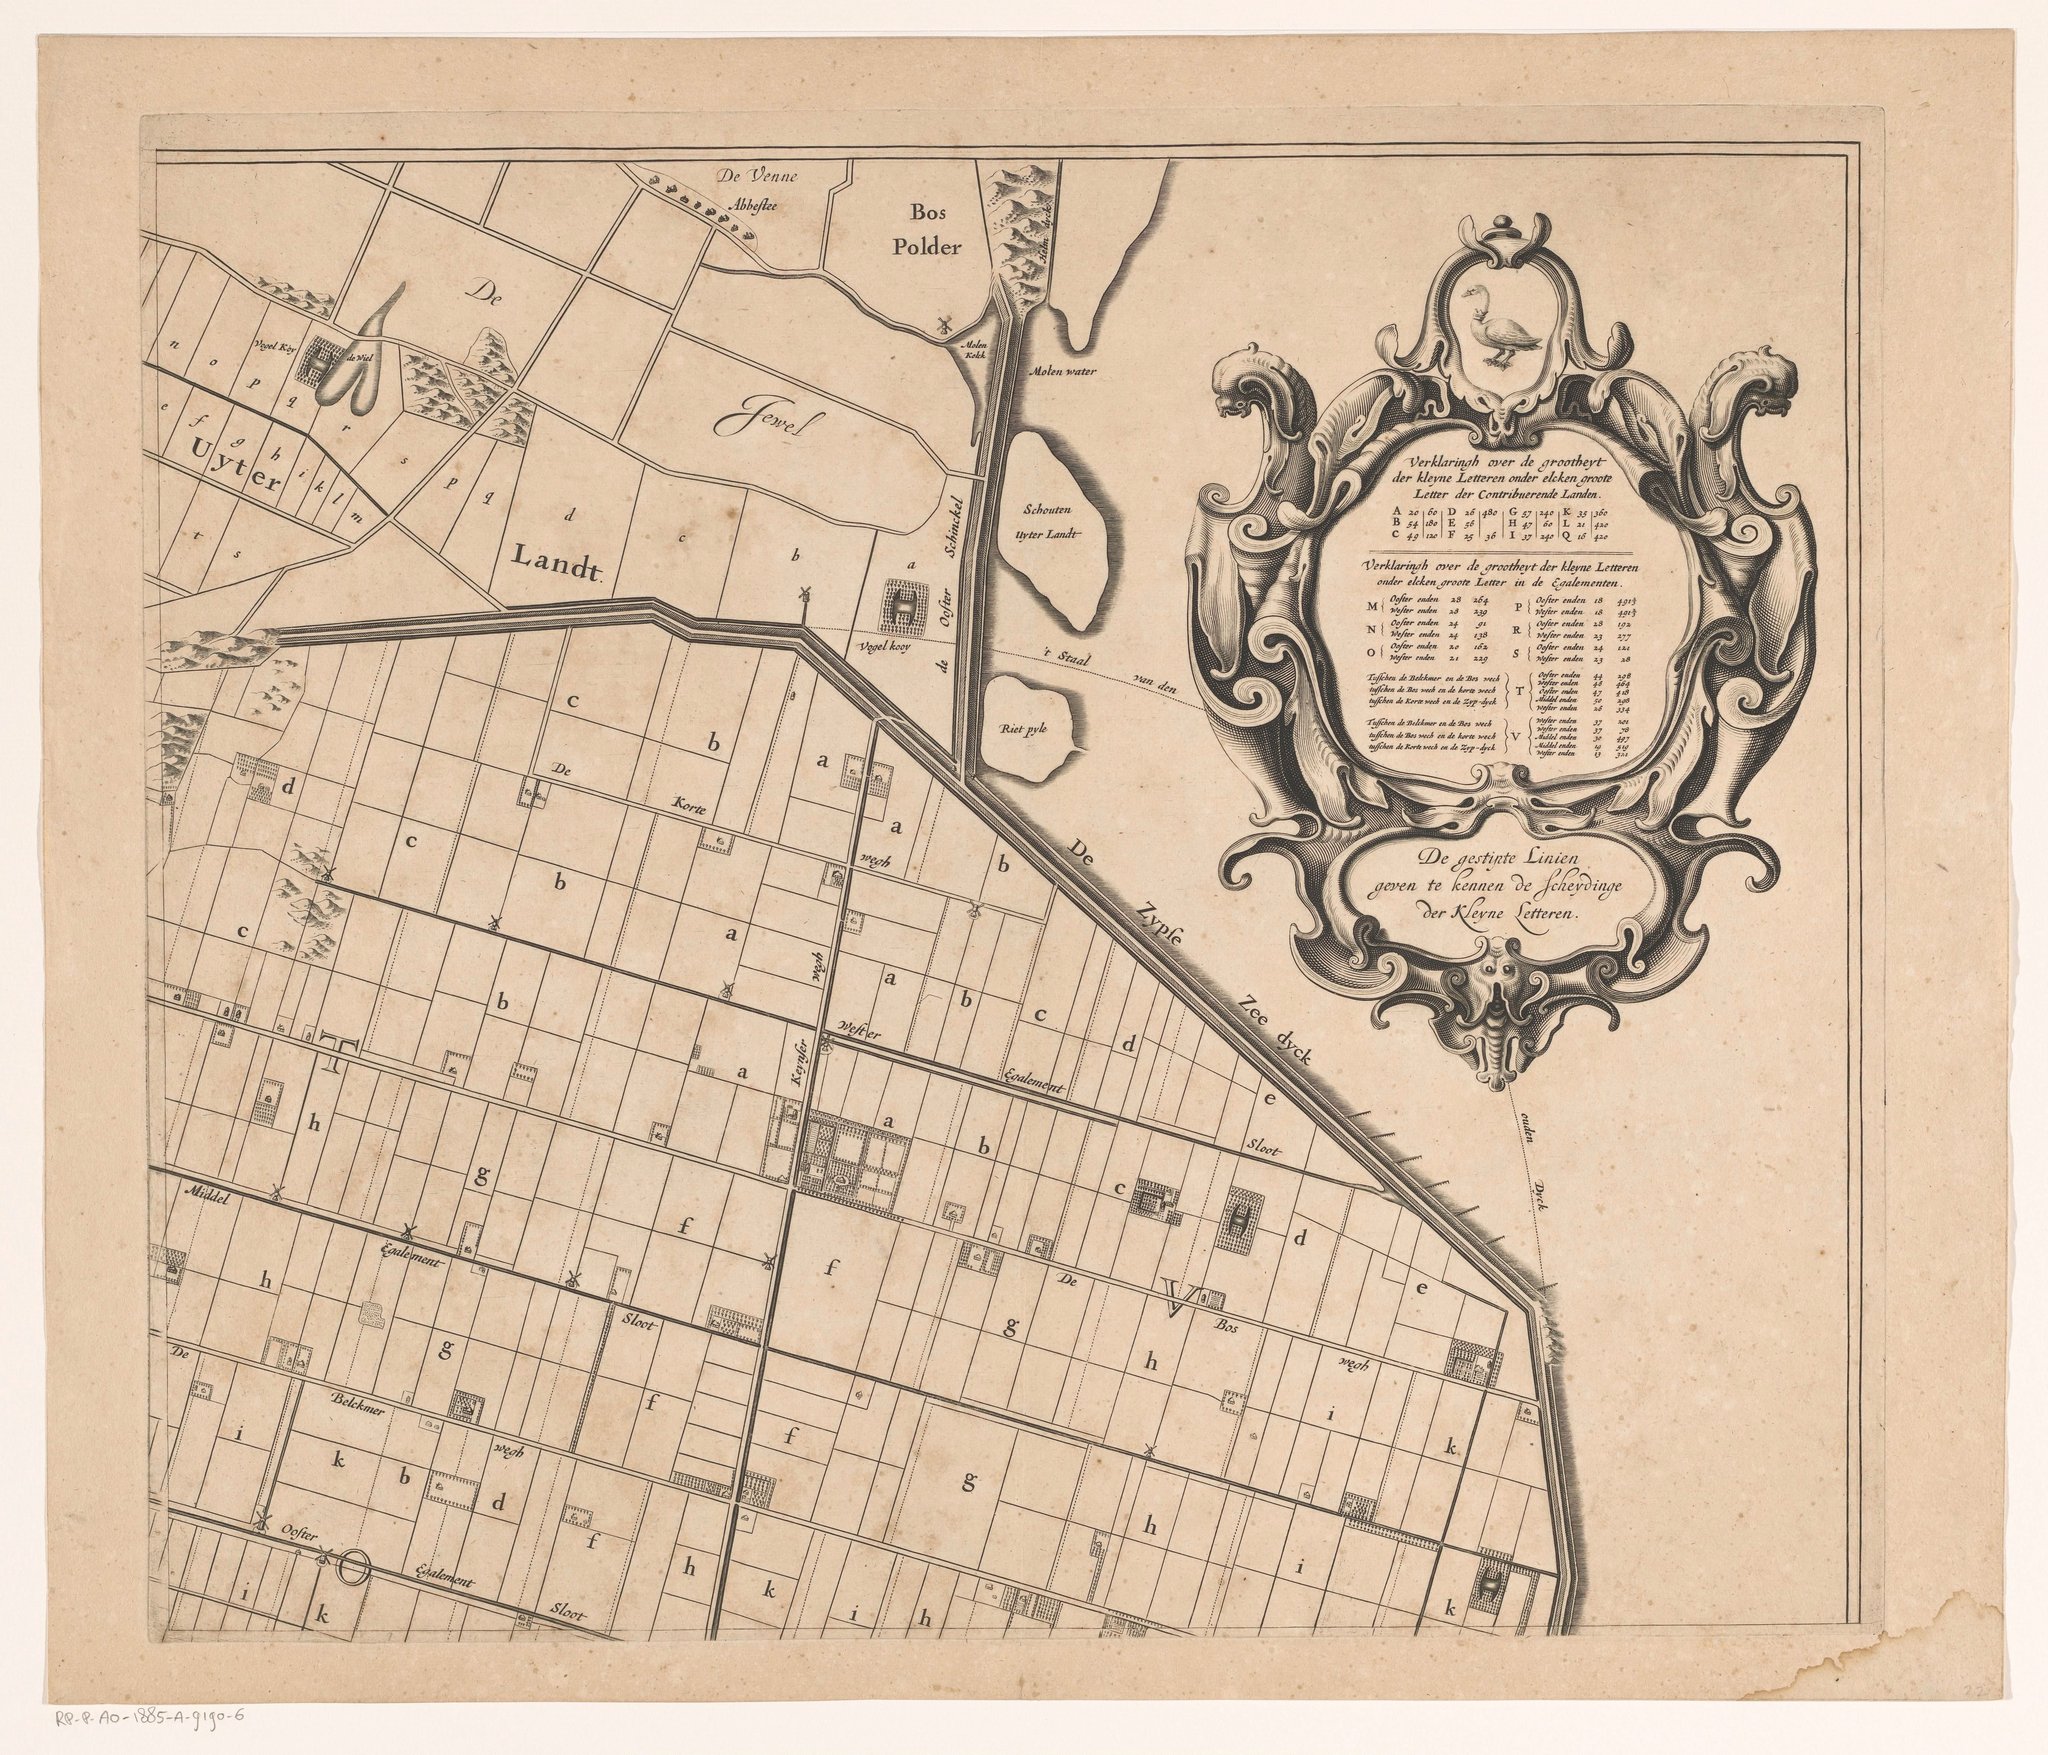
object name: print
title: Kaart van de Zijpe- en Hazepolder (deel rechtsboven)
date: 1665-1760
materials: paper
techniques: engraving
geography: gouda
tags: coat of arms (as symbol of the state, etc.), maps of separate countries or regions, polder, reclaimed land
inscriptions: collector's mark: Lugt 2228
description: Deel (rechtsboven) van een kaart van de Zijpepolder.